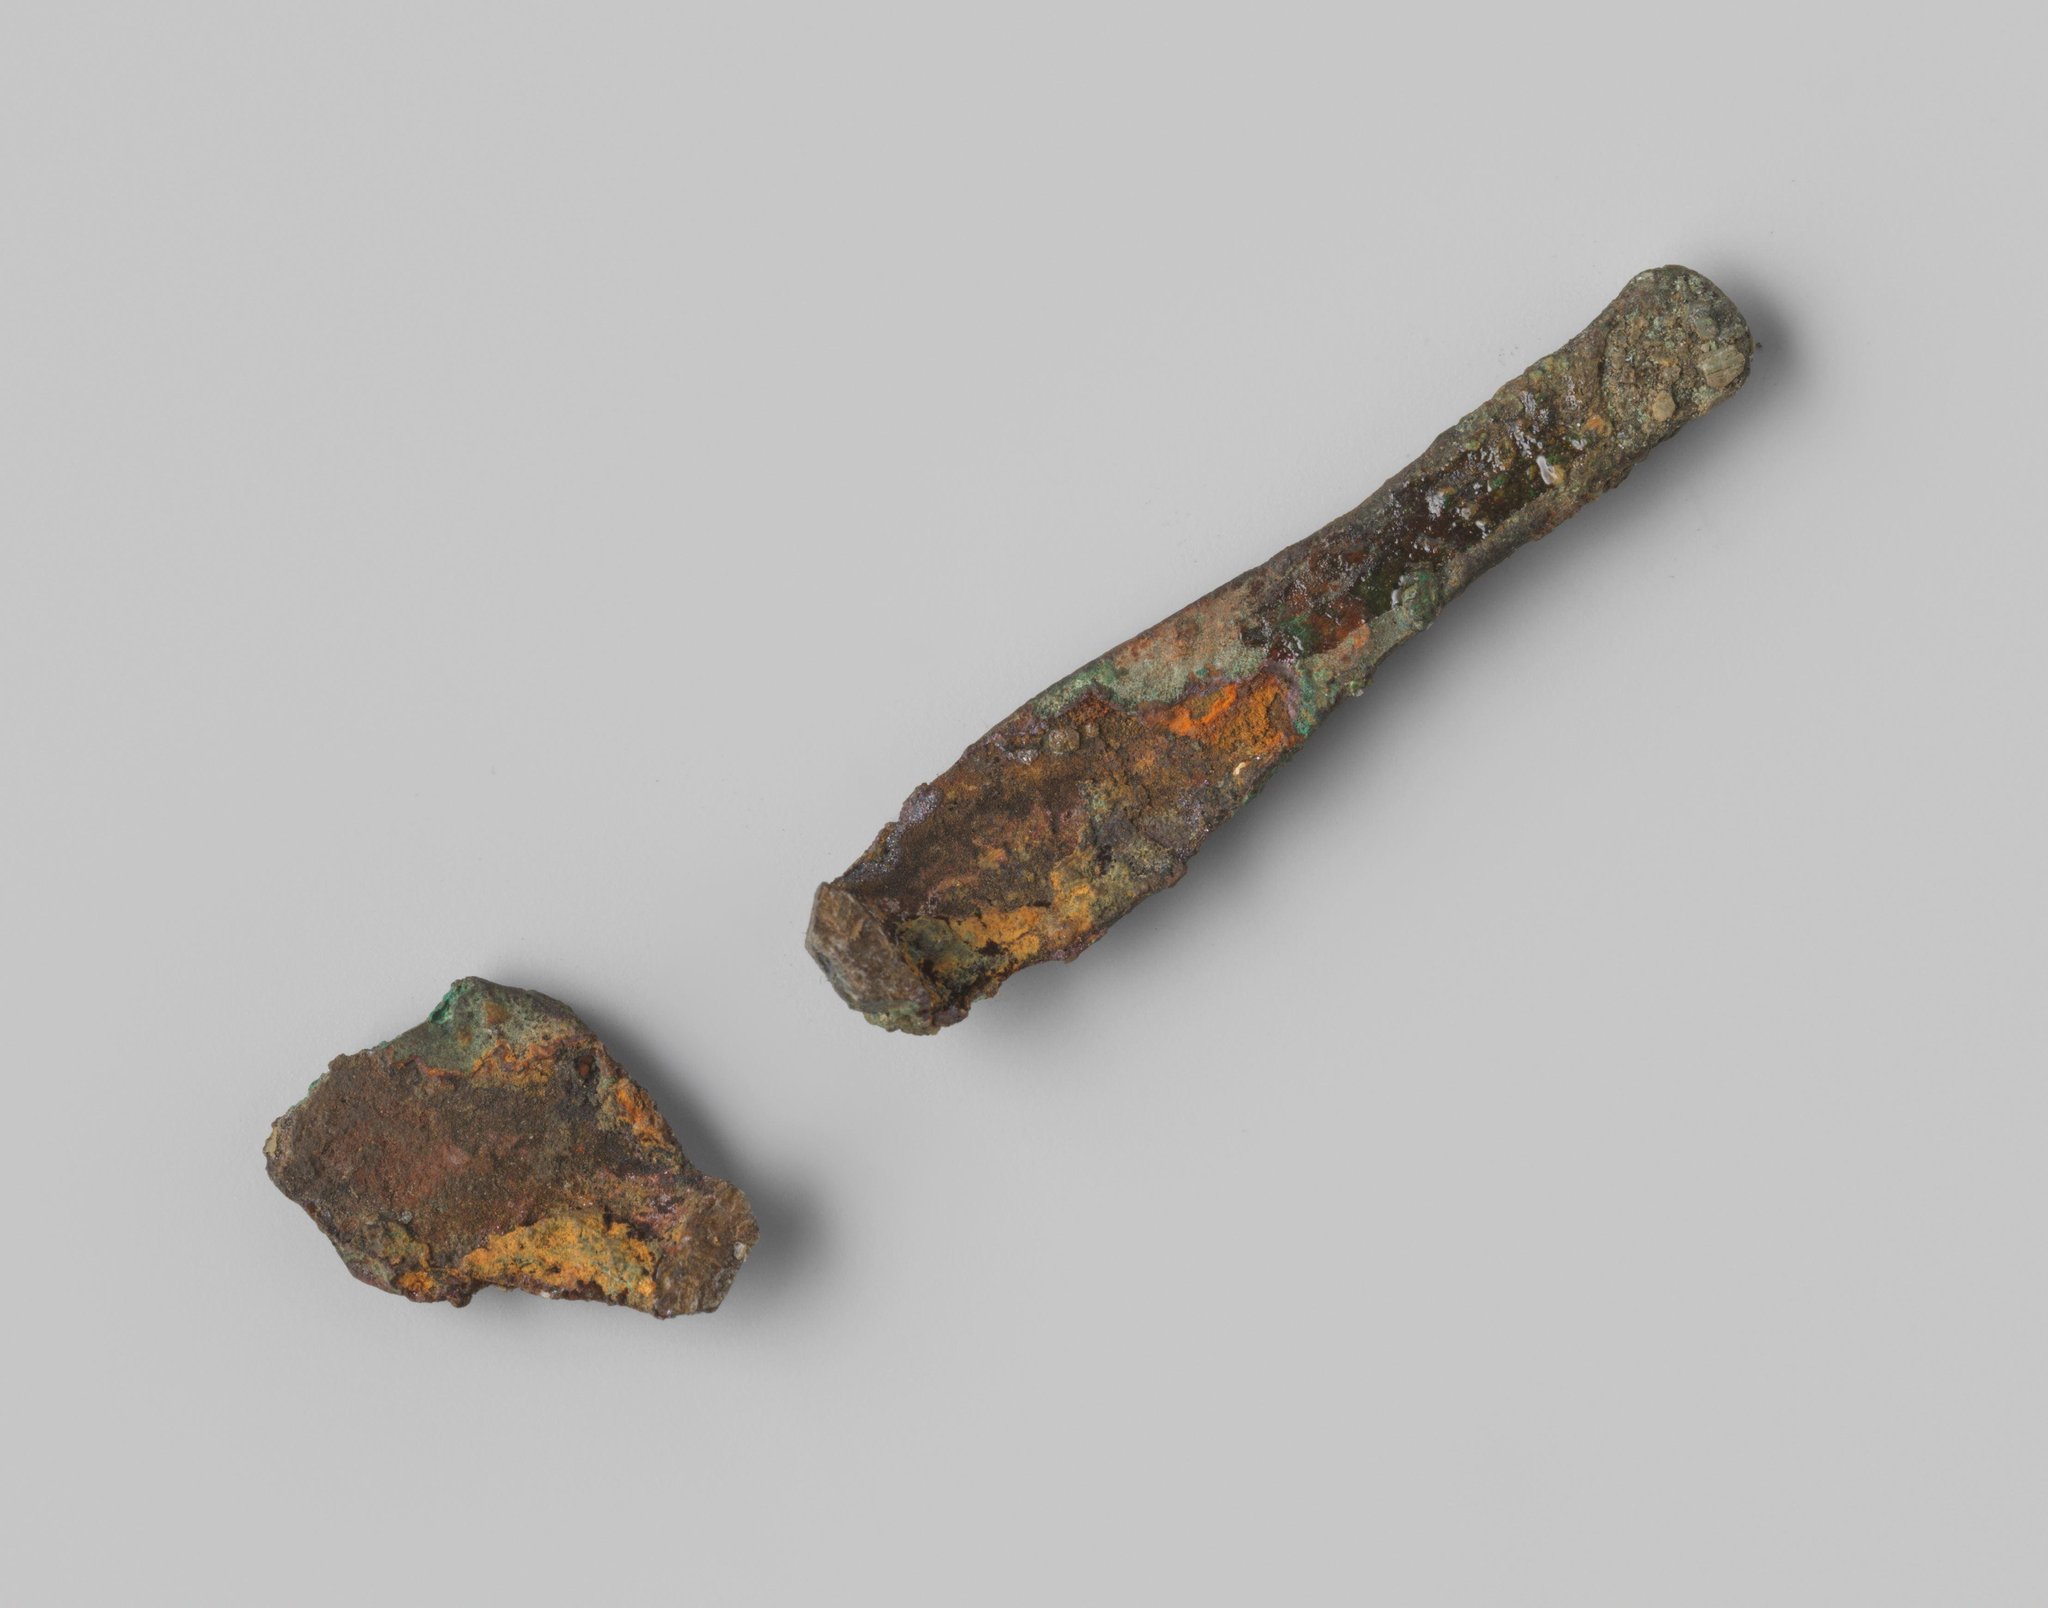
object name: knife with sheath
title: Fragmenten clip van schede uit het wrak van de Oost-Indiëvaarder Hollandia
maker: Anonymous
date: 1700-1743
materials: copper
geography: netherlands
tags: verenigde oostindische compagnie, hollandia (schip), annet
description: Fragm id. NG 1980-27H568, eroded, scabbard.